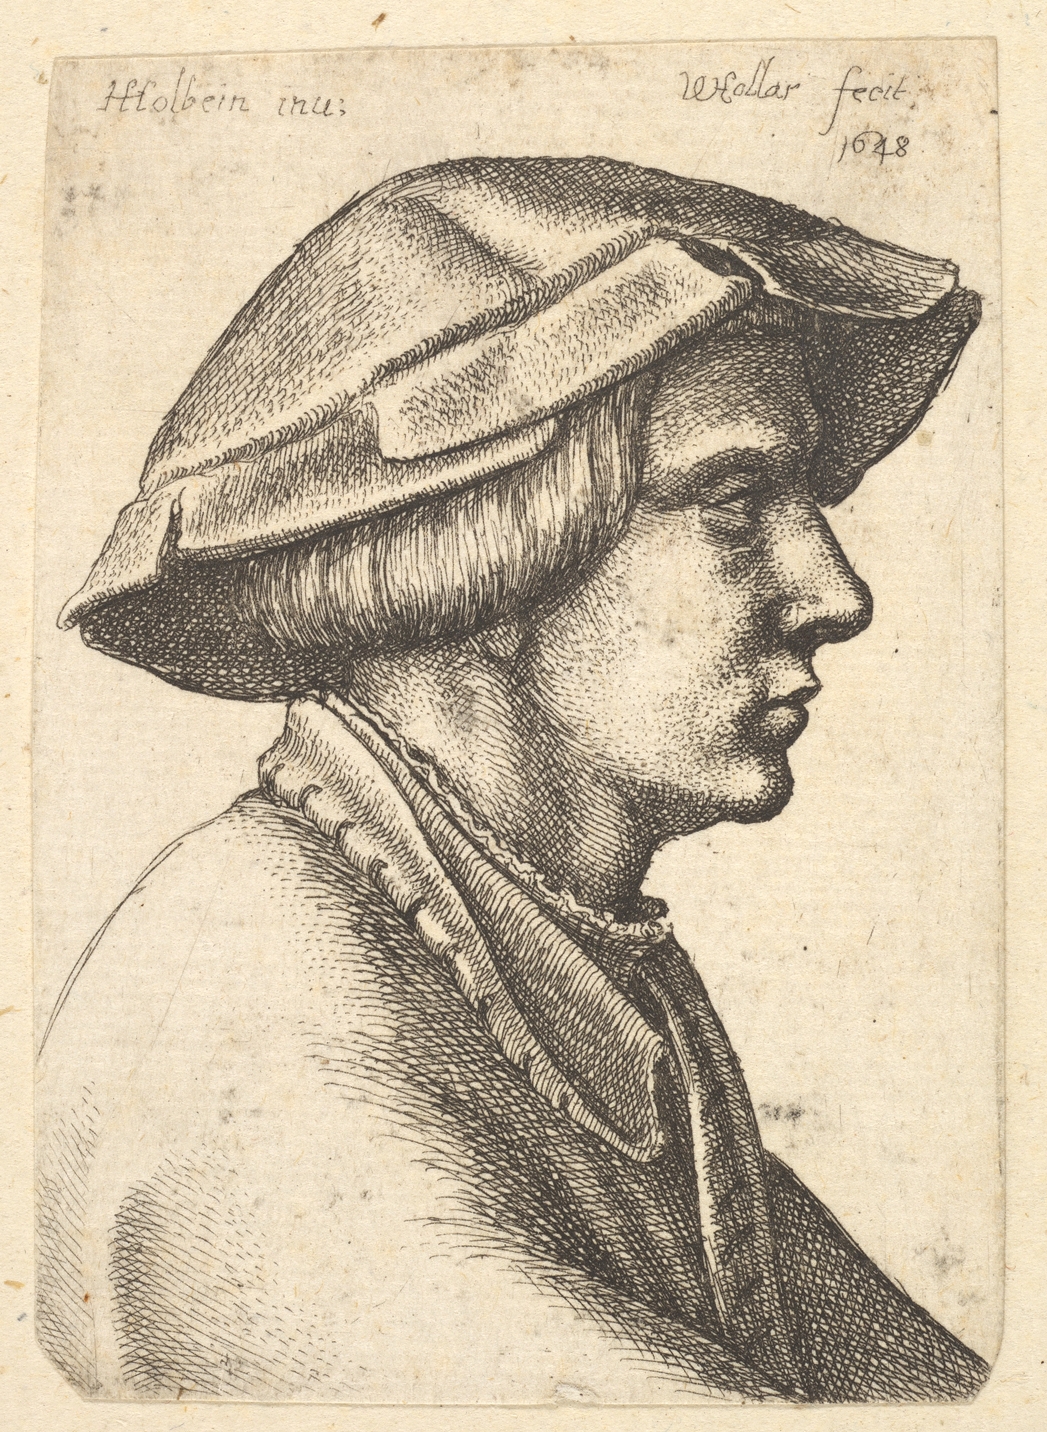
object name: print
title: Head of young man wearing hat in profile to right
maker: wenceslaus hollar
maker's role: artist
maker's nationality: bohemian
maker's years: 1607-1677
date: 1648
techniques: etching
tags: heads,men